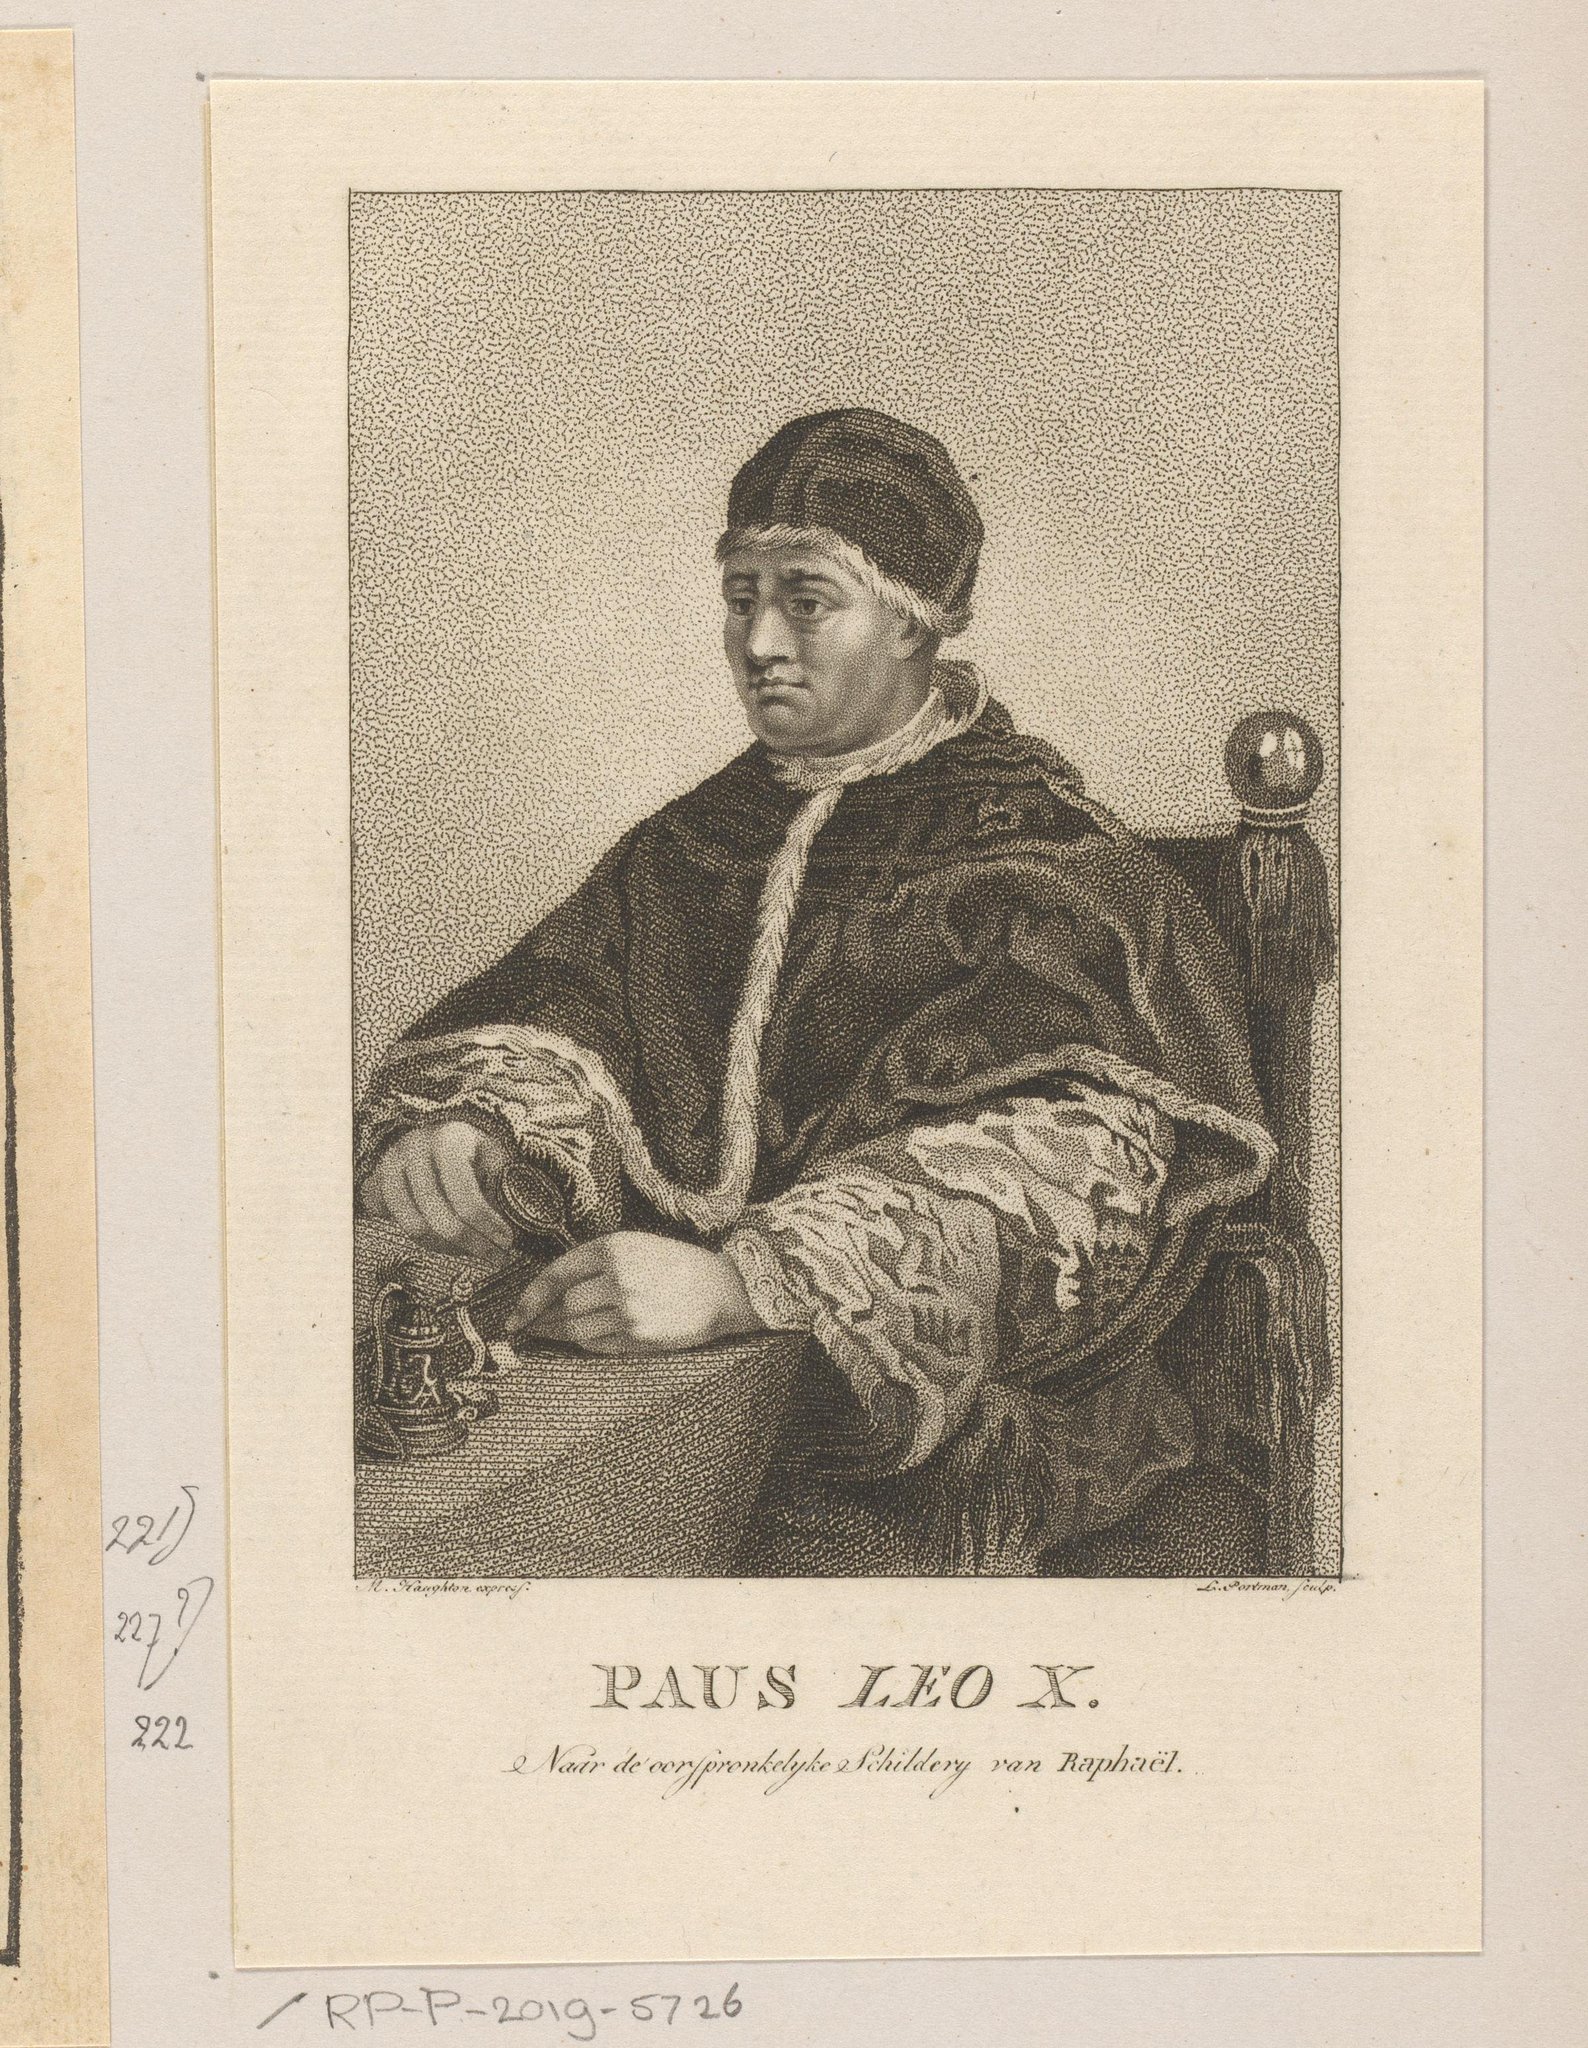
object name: book illustration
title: Paus Leo X. Naar 'de' oorspronkelijke schilderij van Raphaël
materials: paper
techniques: engraving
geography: london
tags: rome, leo x, historical persons, pope